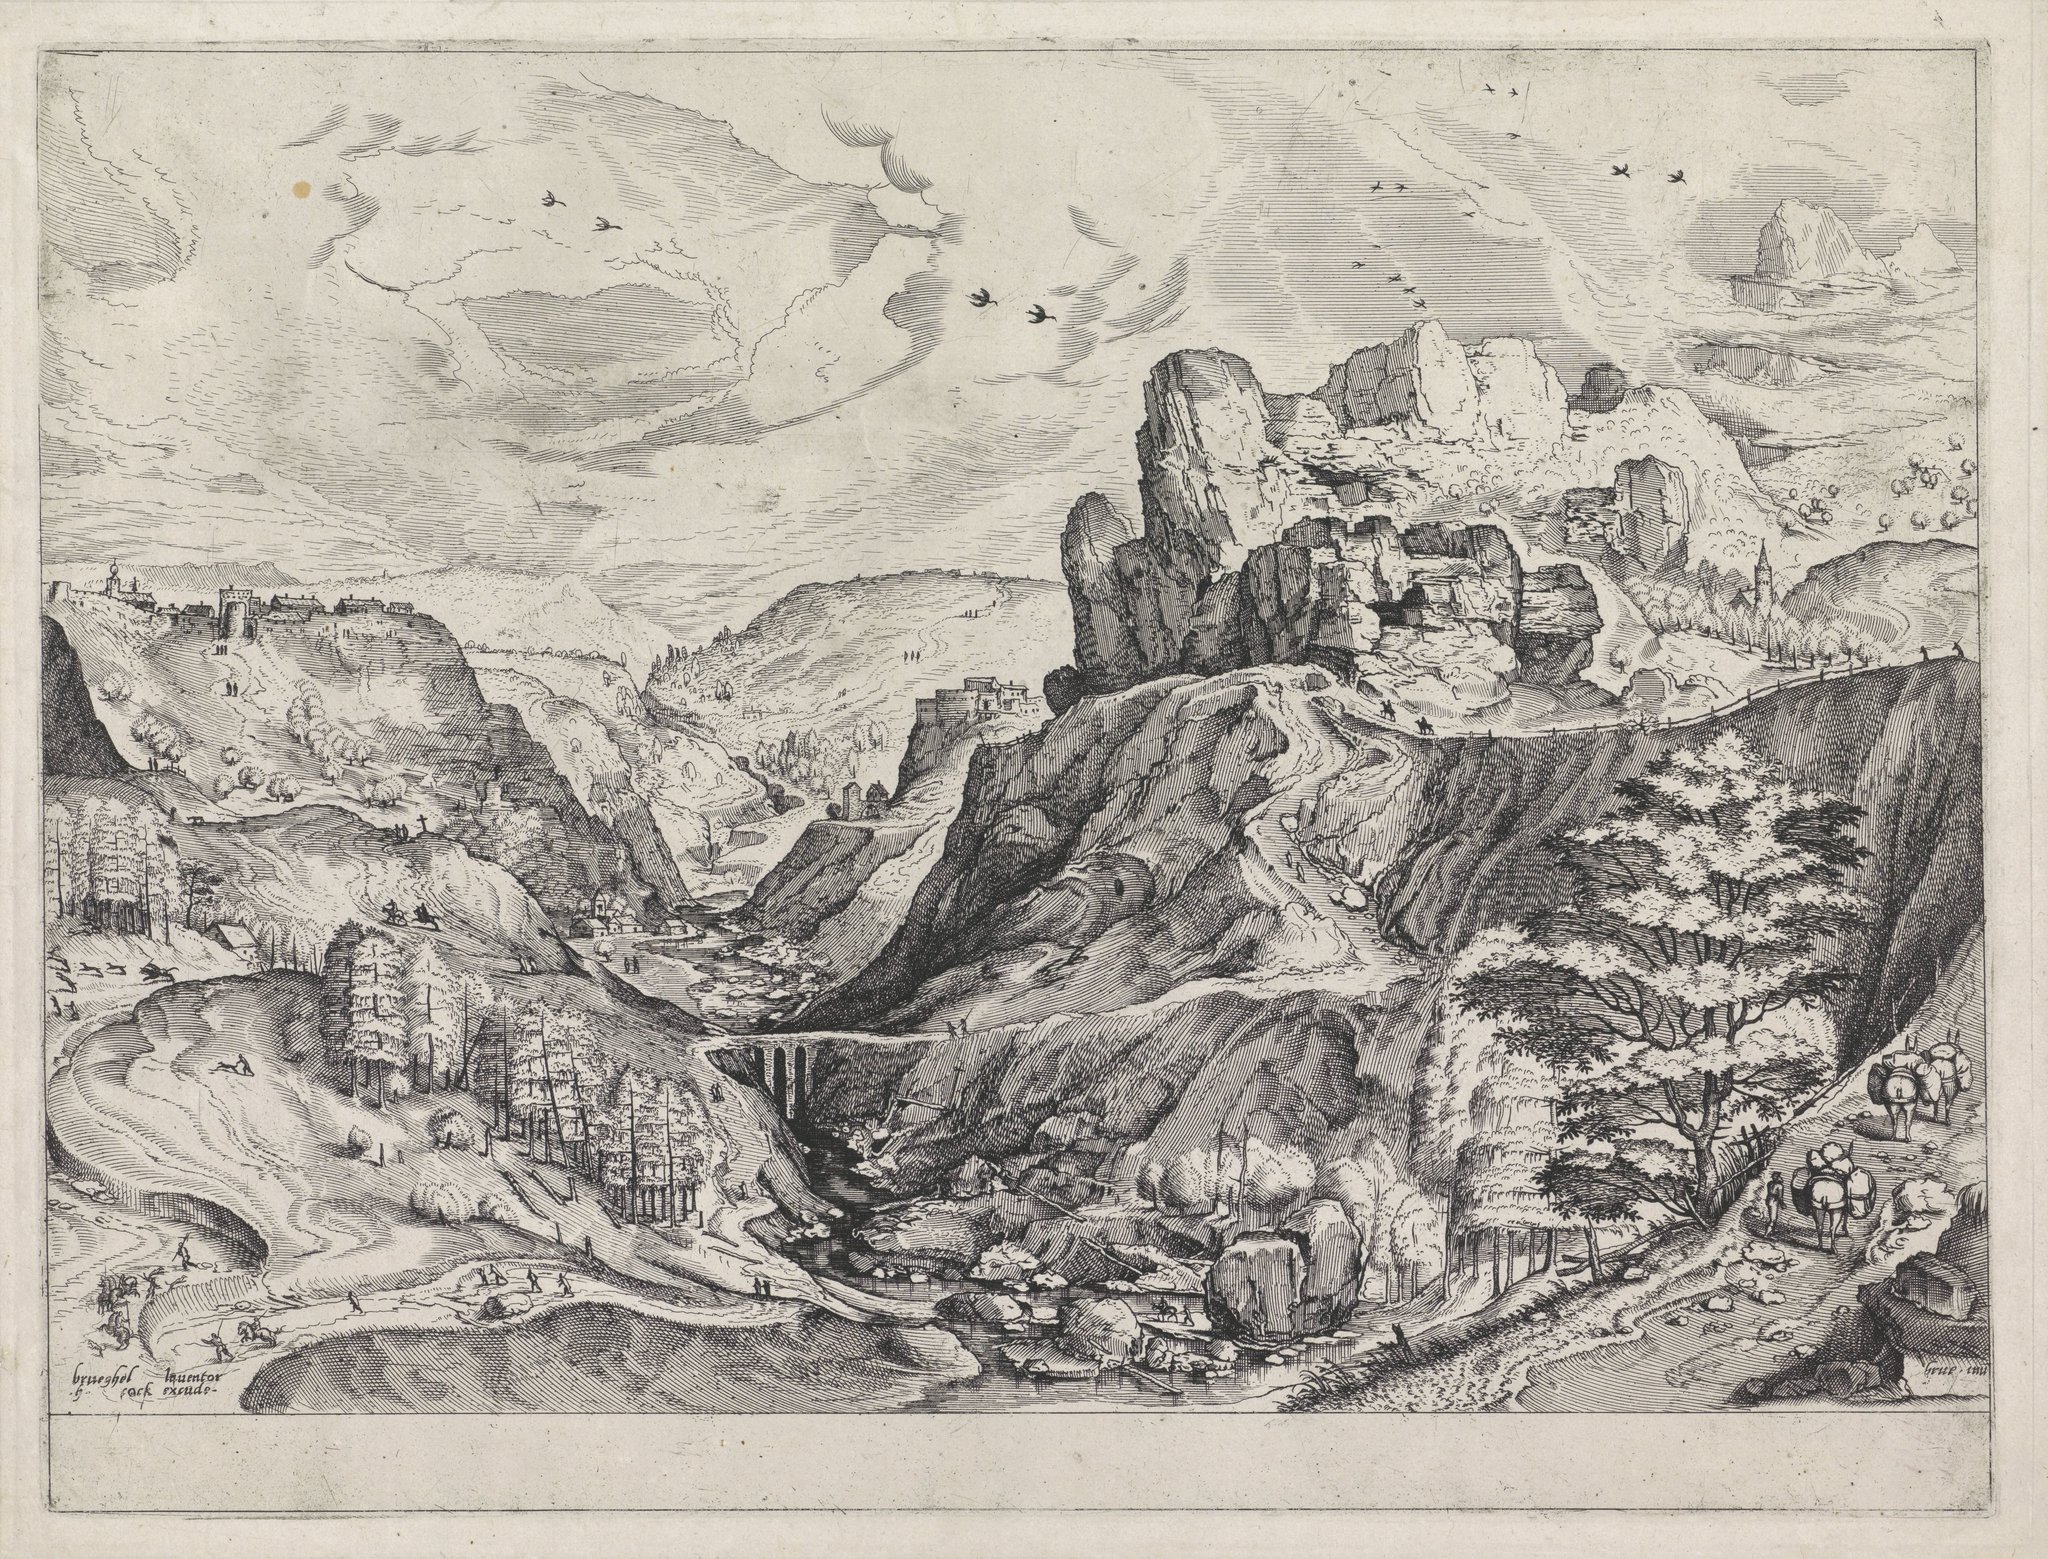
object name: print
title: Alpenlandschap met een diepe vallei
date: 1553-1558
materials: paper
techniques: engraving, etching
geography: antwerp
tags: dale, valley, mountains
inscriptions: collector's mark: Lugt 240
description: Alpenlandschap met een vallei waardoor een beek stroomt. Rechts op de voorgrond een man met drie pakezels.